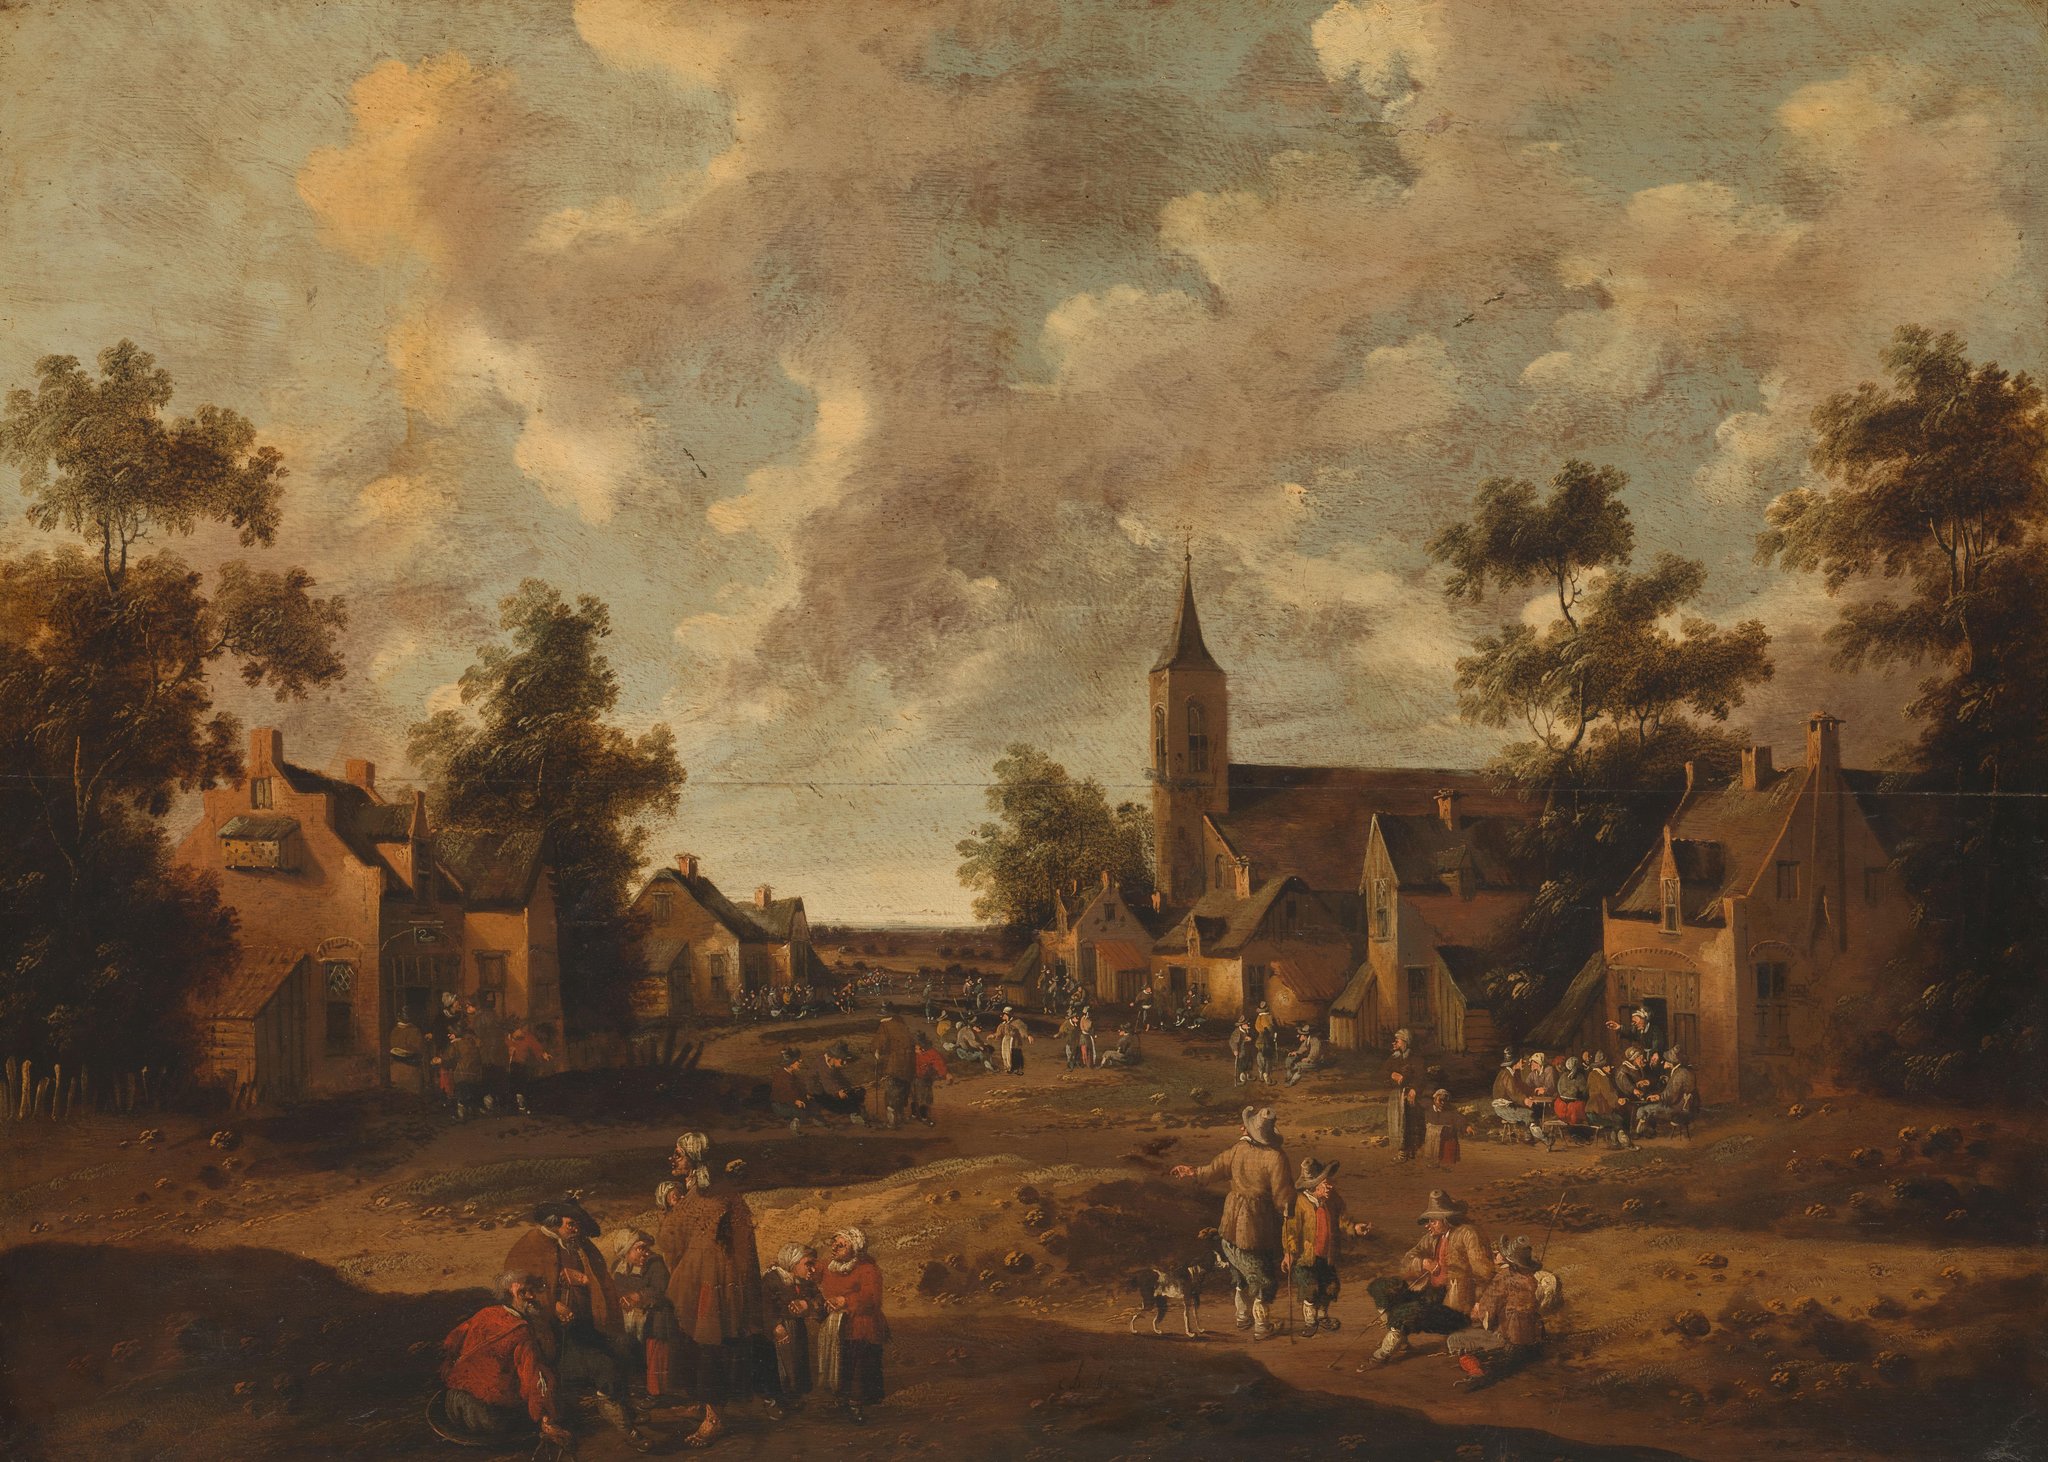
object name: painting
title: Village Street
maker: cornelis droochsloot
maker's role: painter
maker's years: 1630-1673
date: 1664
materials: oil, panel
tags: church (exterior), public road in village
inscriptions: signature and date: ‘c. drooghsloot 1664’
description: Dorpsgezicht met overal groepen personen voor de woningen. Rechts een gezelschap aan tafels buiten een herberg, in de verte een kerk.